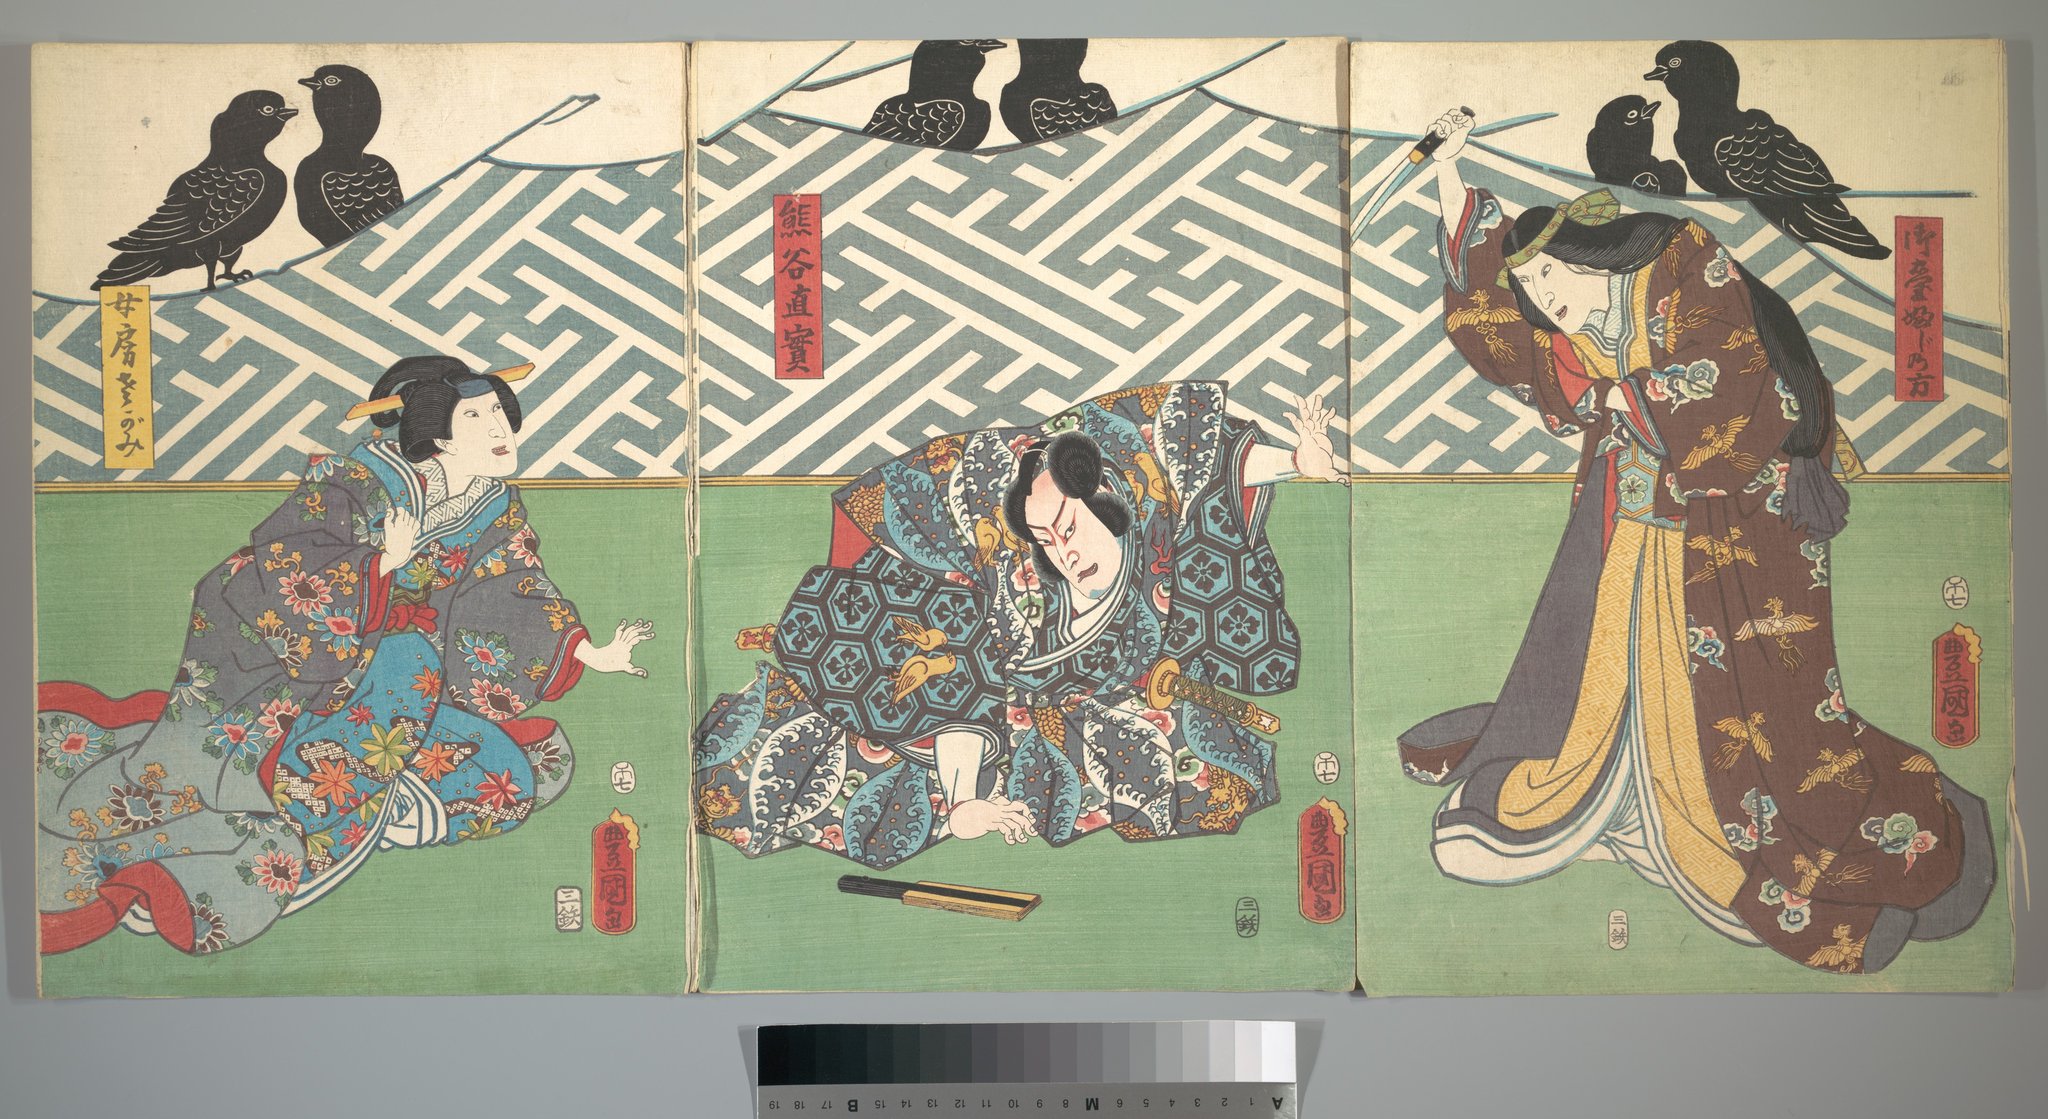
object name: print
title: Three Actors on Stage: Kumagai Naozane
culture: japanese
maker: utagawa kunisada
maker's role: artist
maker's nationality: japanese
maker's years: 1786-1864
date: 1858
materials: ink, paper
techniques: woodblock print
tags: human figures,birds,performance,actors